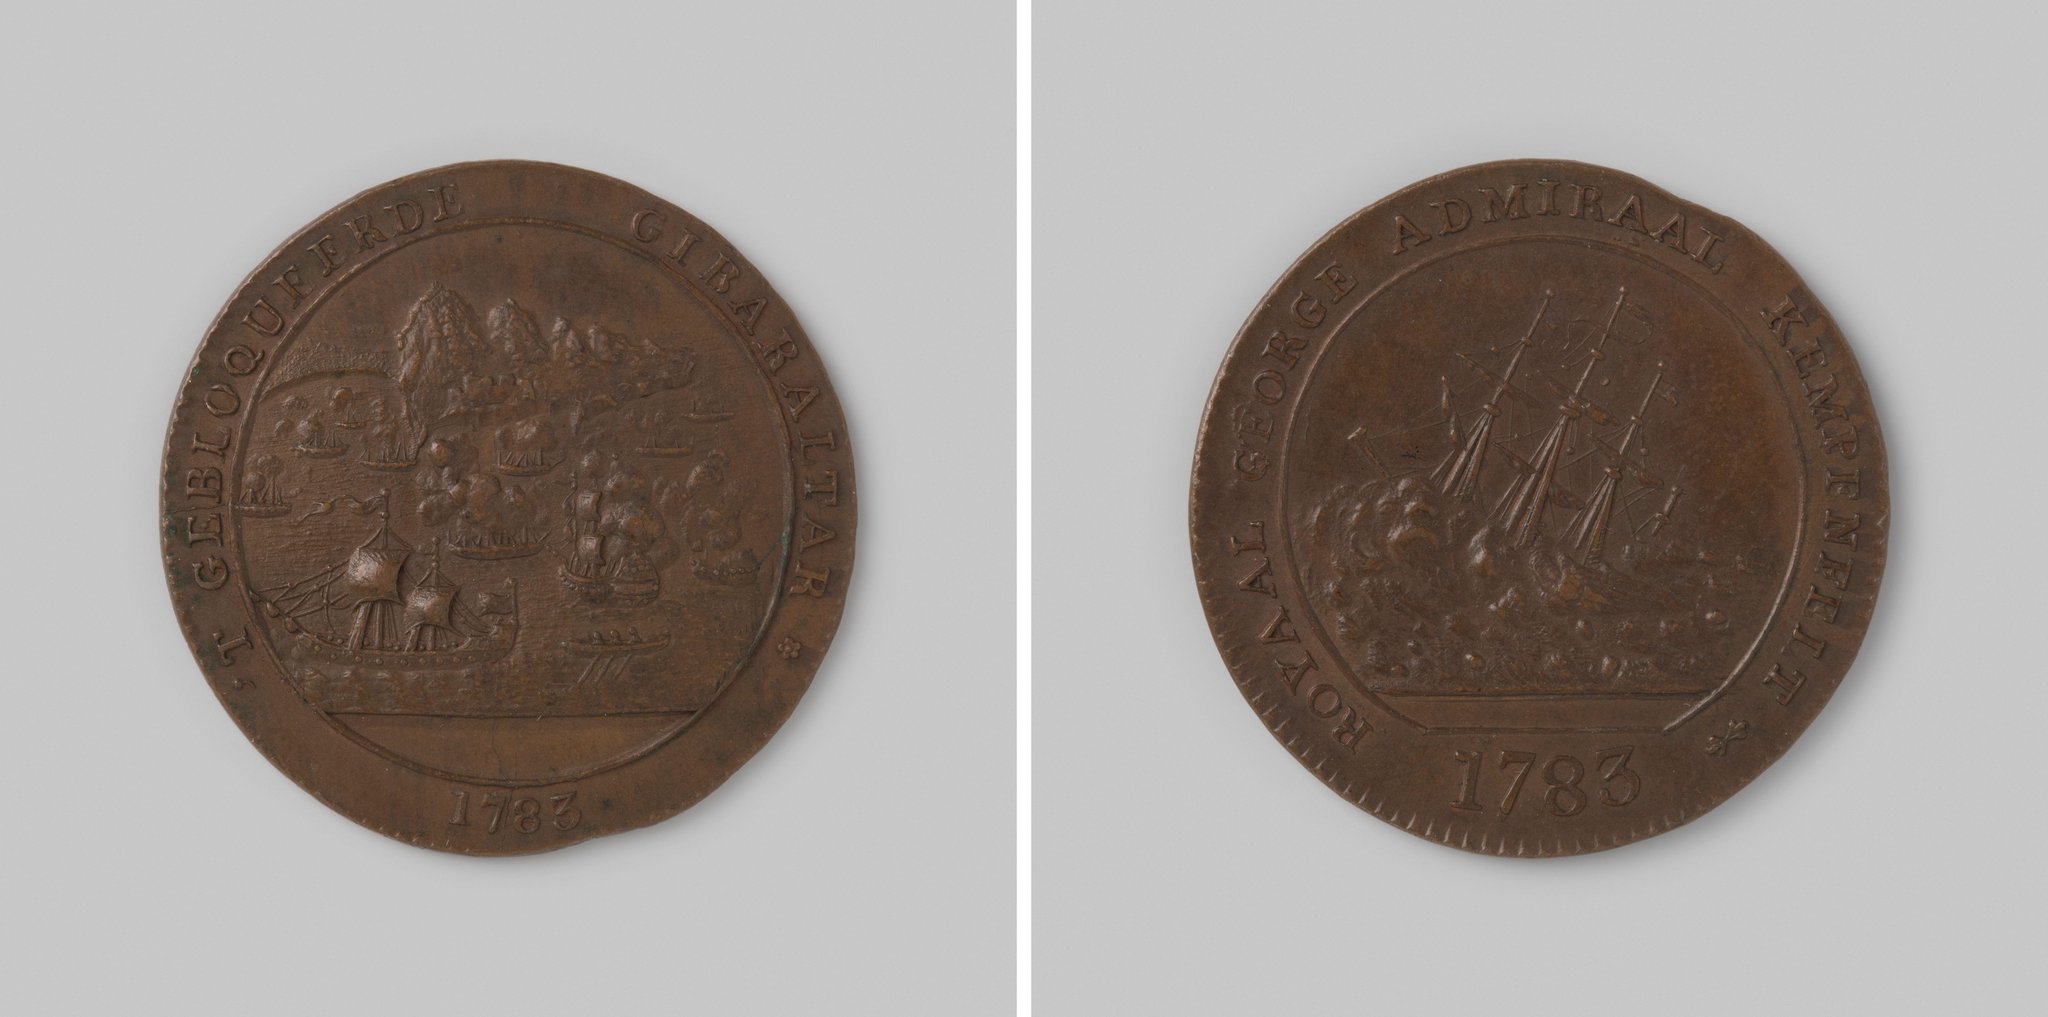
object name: history medal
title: De blokkade van Gibraltar en het zinken van de Royal George 1783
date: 1783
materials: copper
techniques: pressing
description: Koperen penning, op de voorzijde oorlogsschepen die Gibraltar beschieten, met omschrift, op de keerzijde een zinkende driemaster, met omschrift.